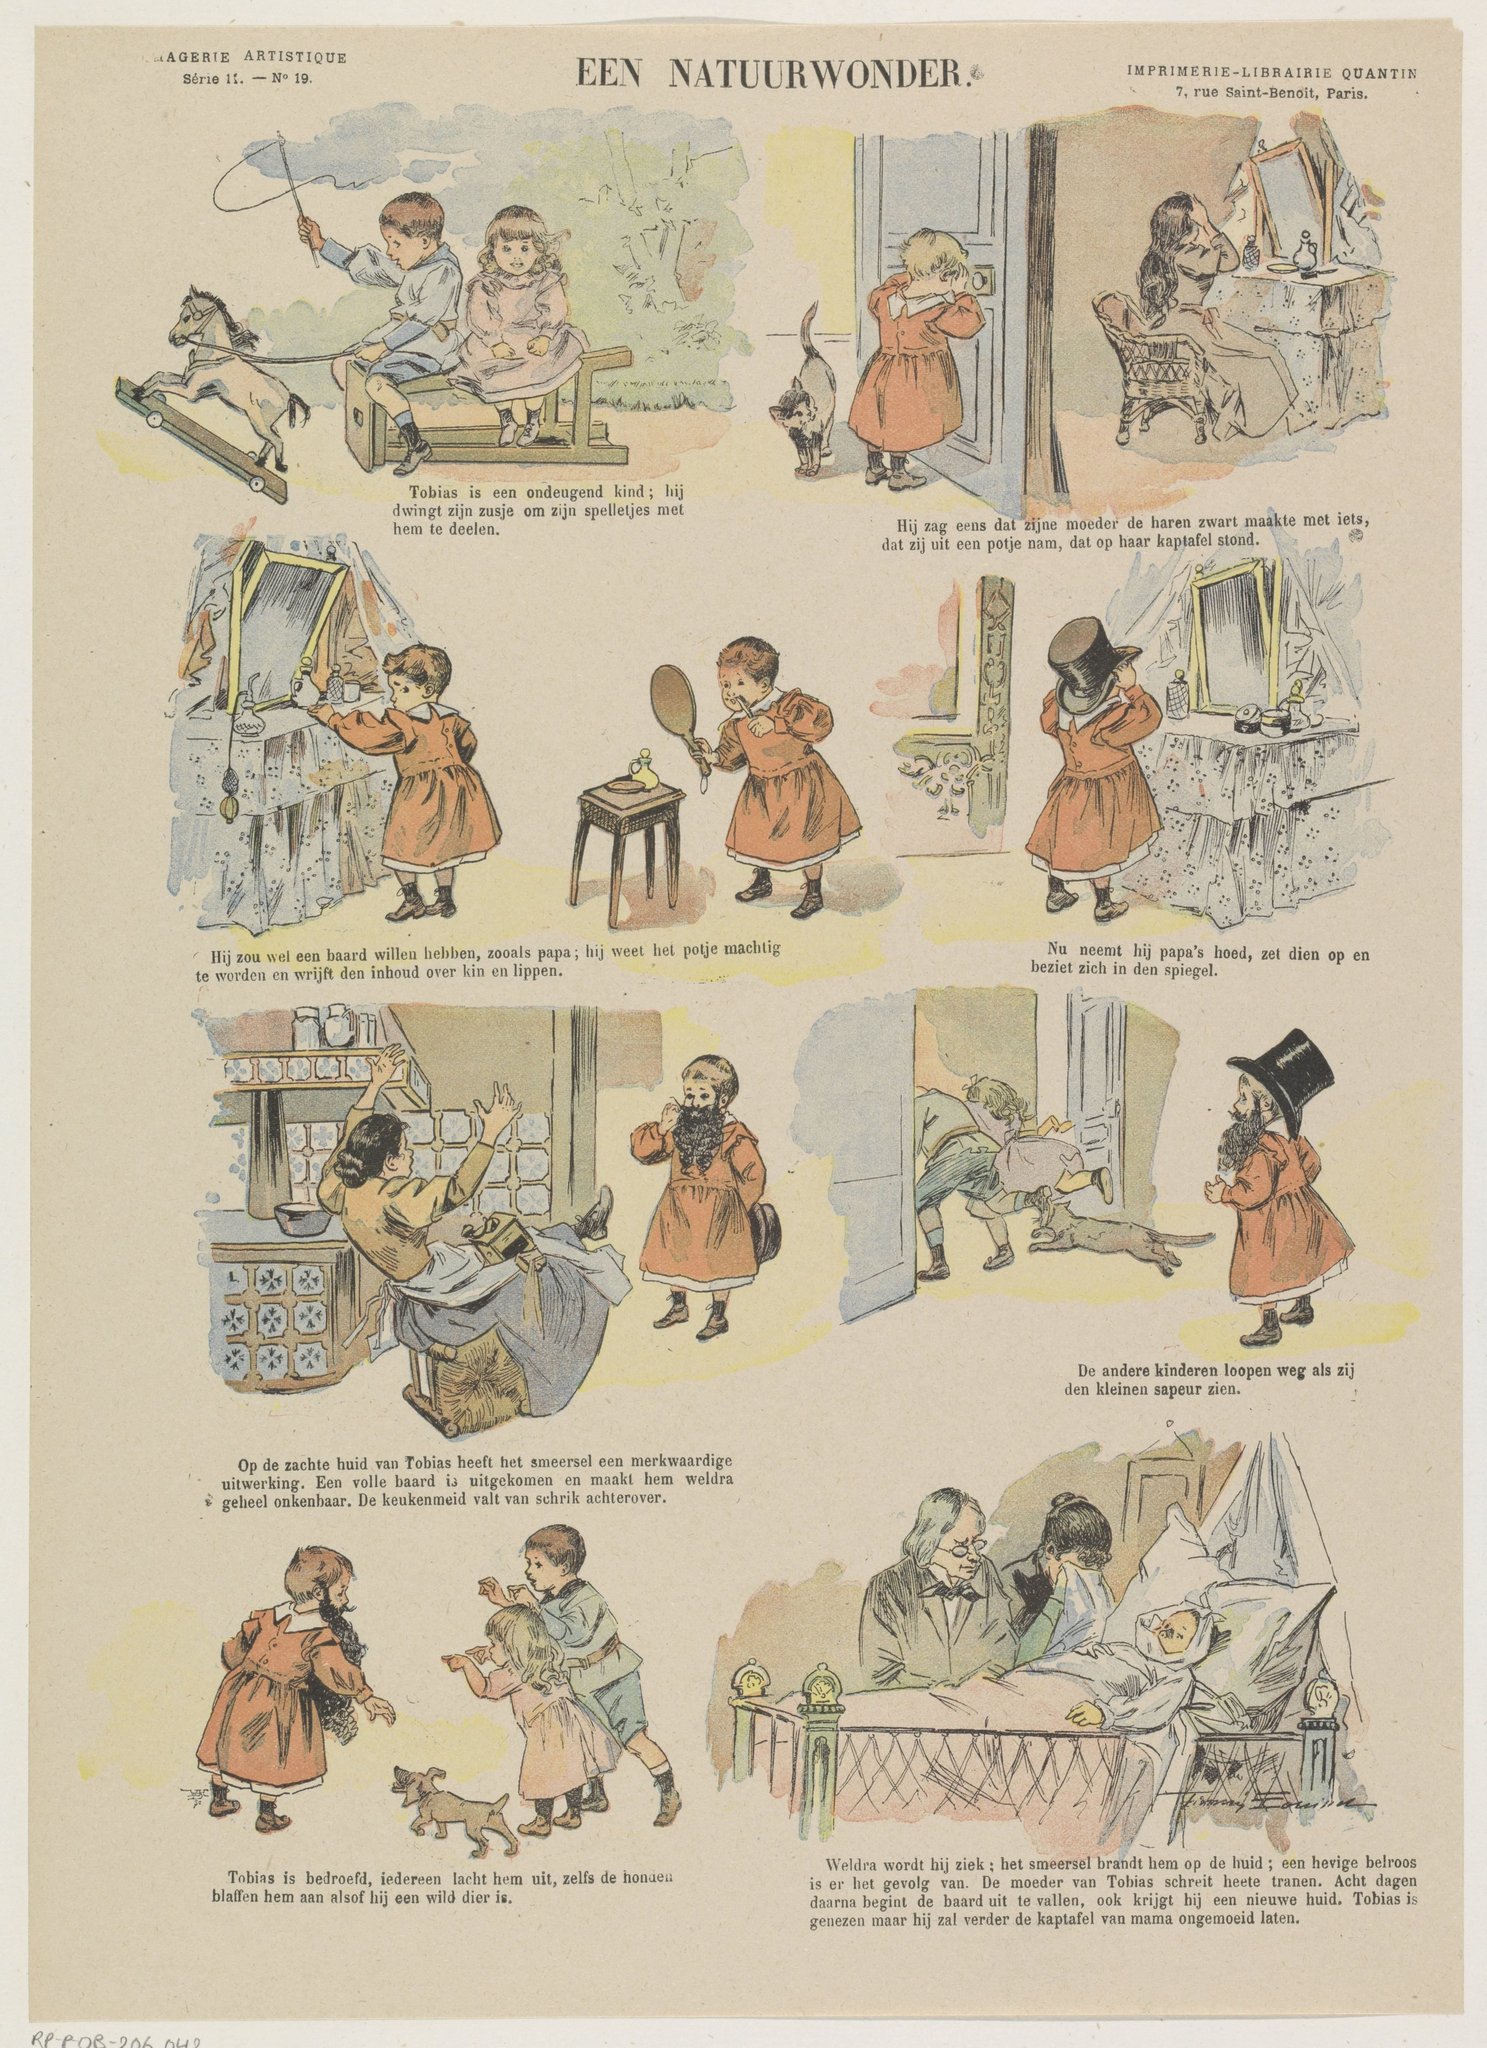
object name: print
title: Imagerie Artistique / Série 11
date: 1876-1890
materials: paper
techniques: lithograph, letterpress printing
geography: paris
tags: sick-bed, tales and fairy tales, beard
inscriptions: collector's mark: Lugt 2760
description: Blad met 9 voorstellingen van de kleine Tobias die een middel op zijn kin smeert en een lange baard krijgt. Onder elke afbeelding een onderschrift. Genummerd linksboven: Série 11. - No. 19.